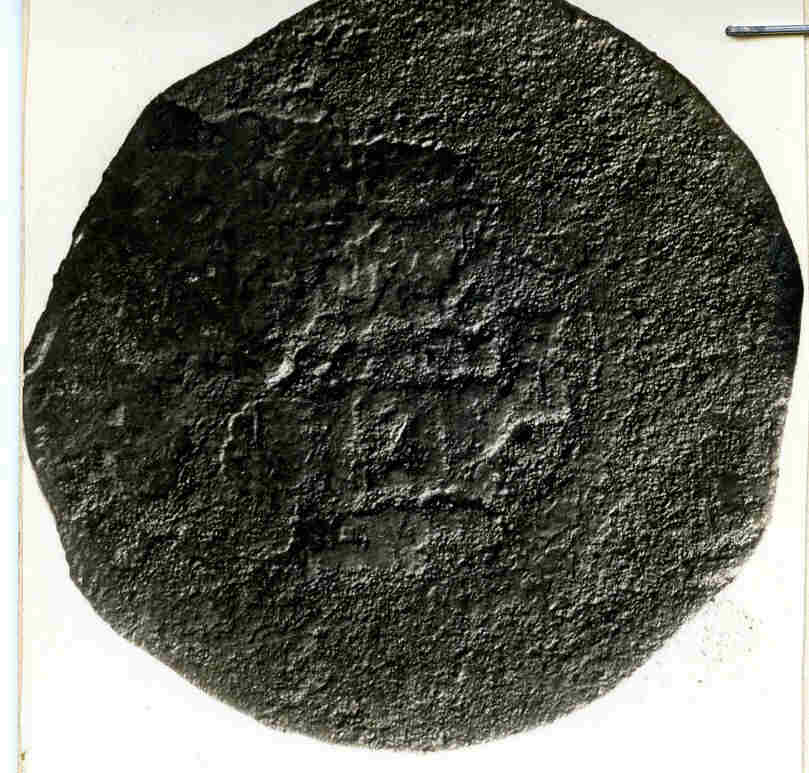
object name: coin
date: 401-1400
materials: copper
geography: iran